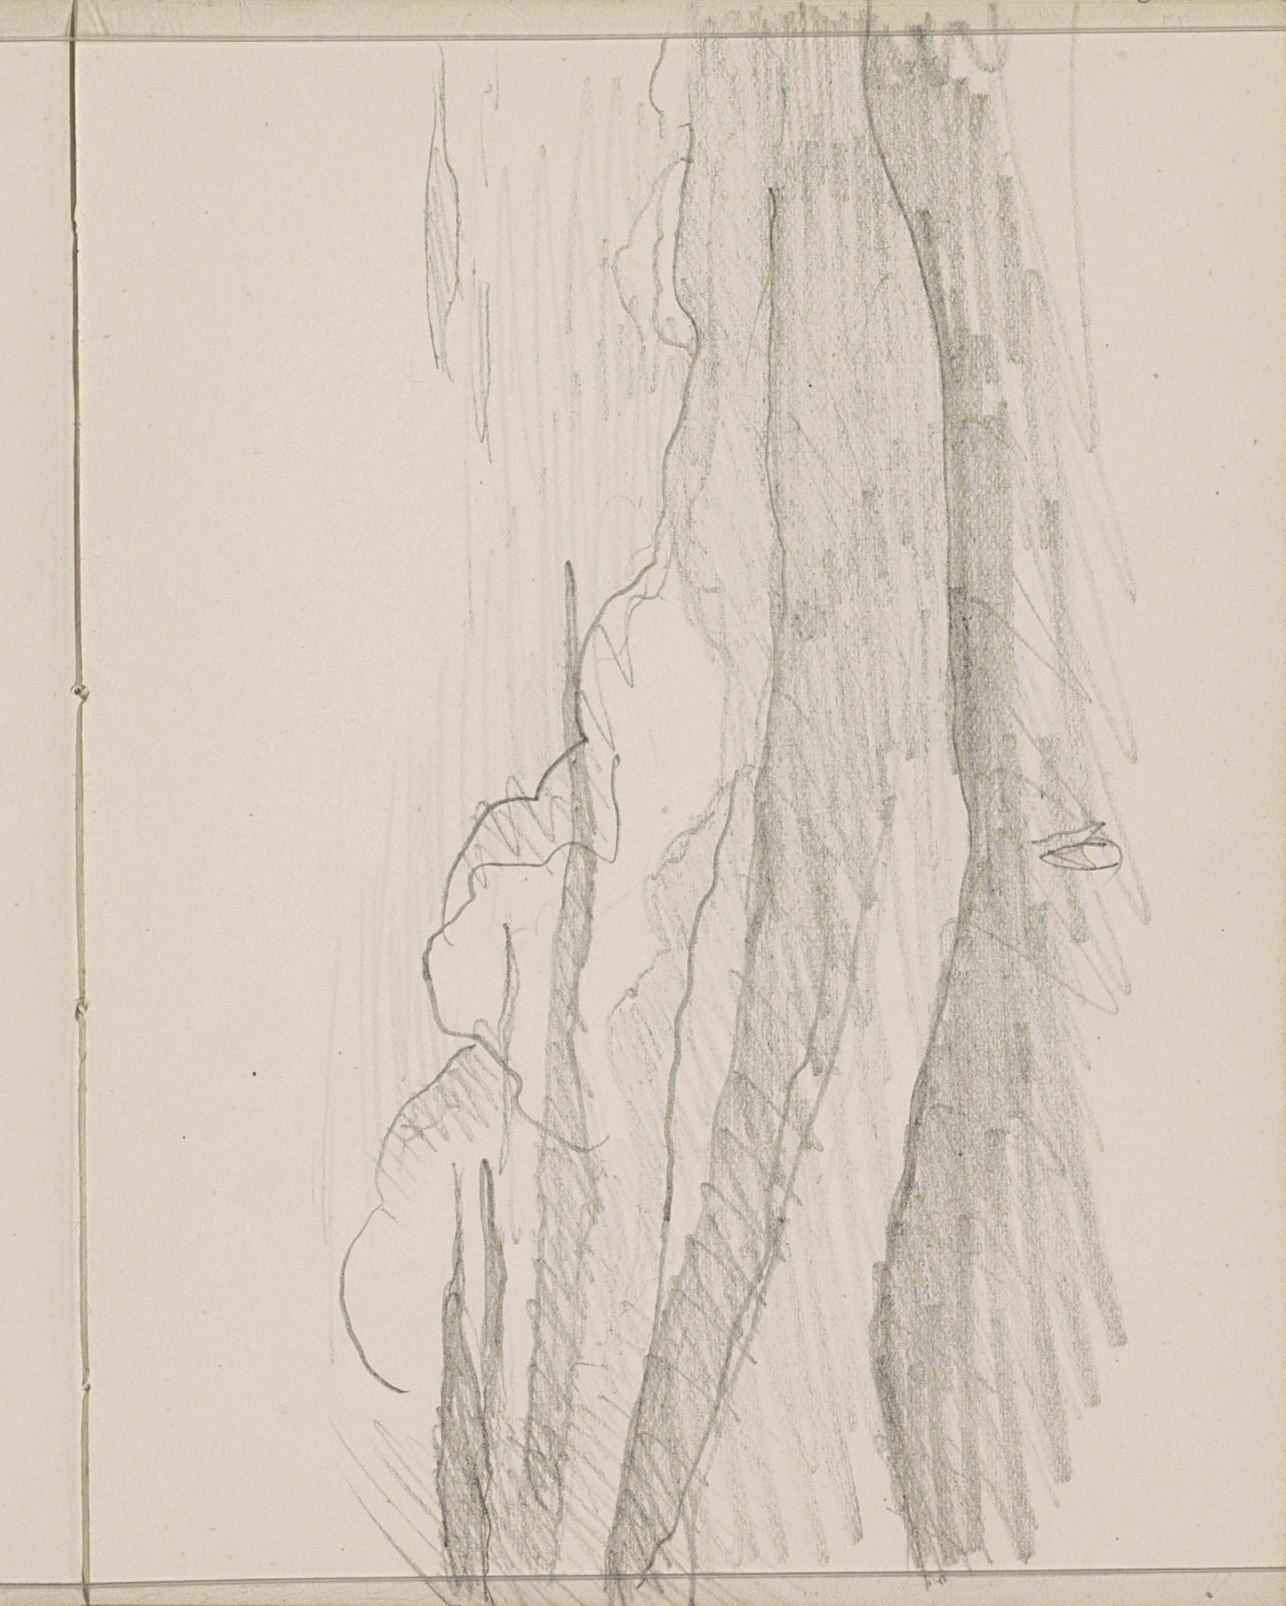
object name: sketchbook leaf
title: Rotskust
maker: reijer stolk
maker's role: draughtsman, print maker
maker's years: 1896-1945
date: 1916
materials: paper, pencil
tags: rocky coast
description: Blad 21 recto uit een schetsboek met 72 bladen.